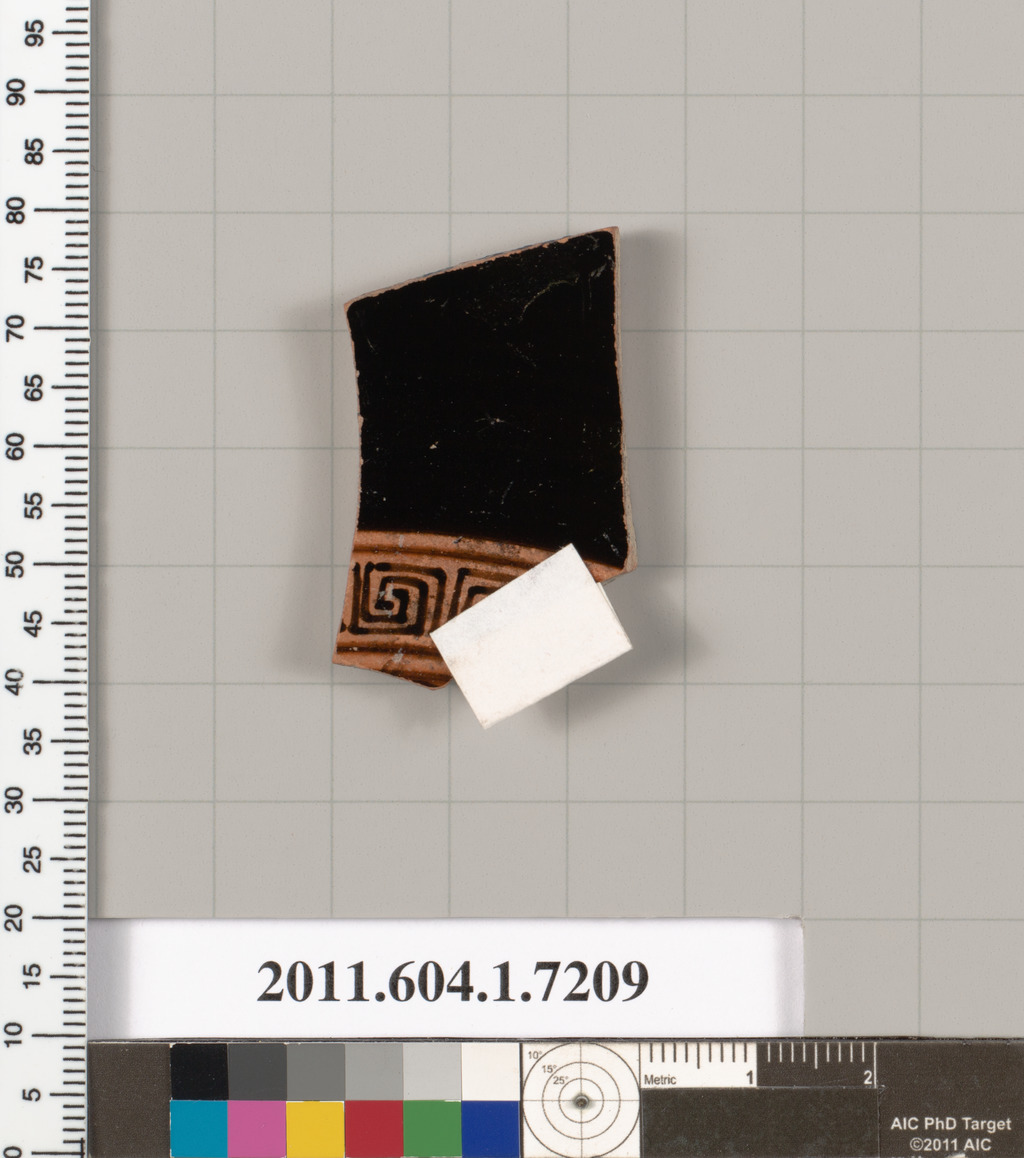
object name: kylix fragment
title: Terracotta fragment of a kylix (drinking cup)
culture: greek, attic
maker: makron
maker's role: artist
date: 500-480 BCE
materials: terracotta